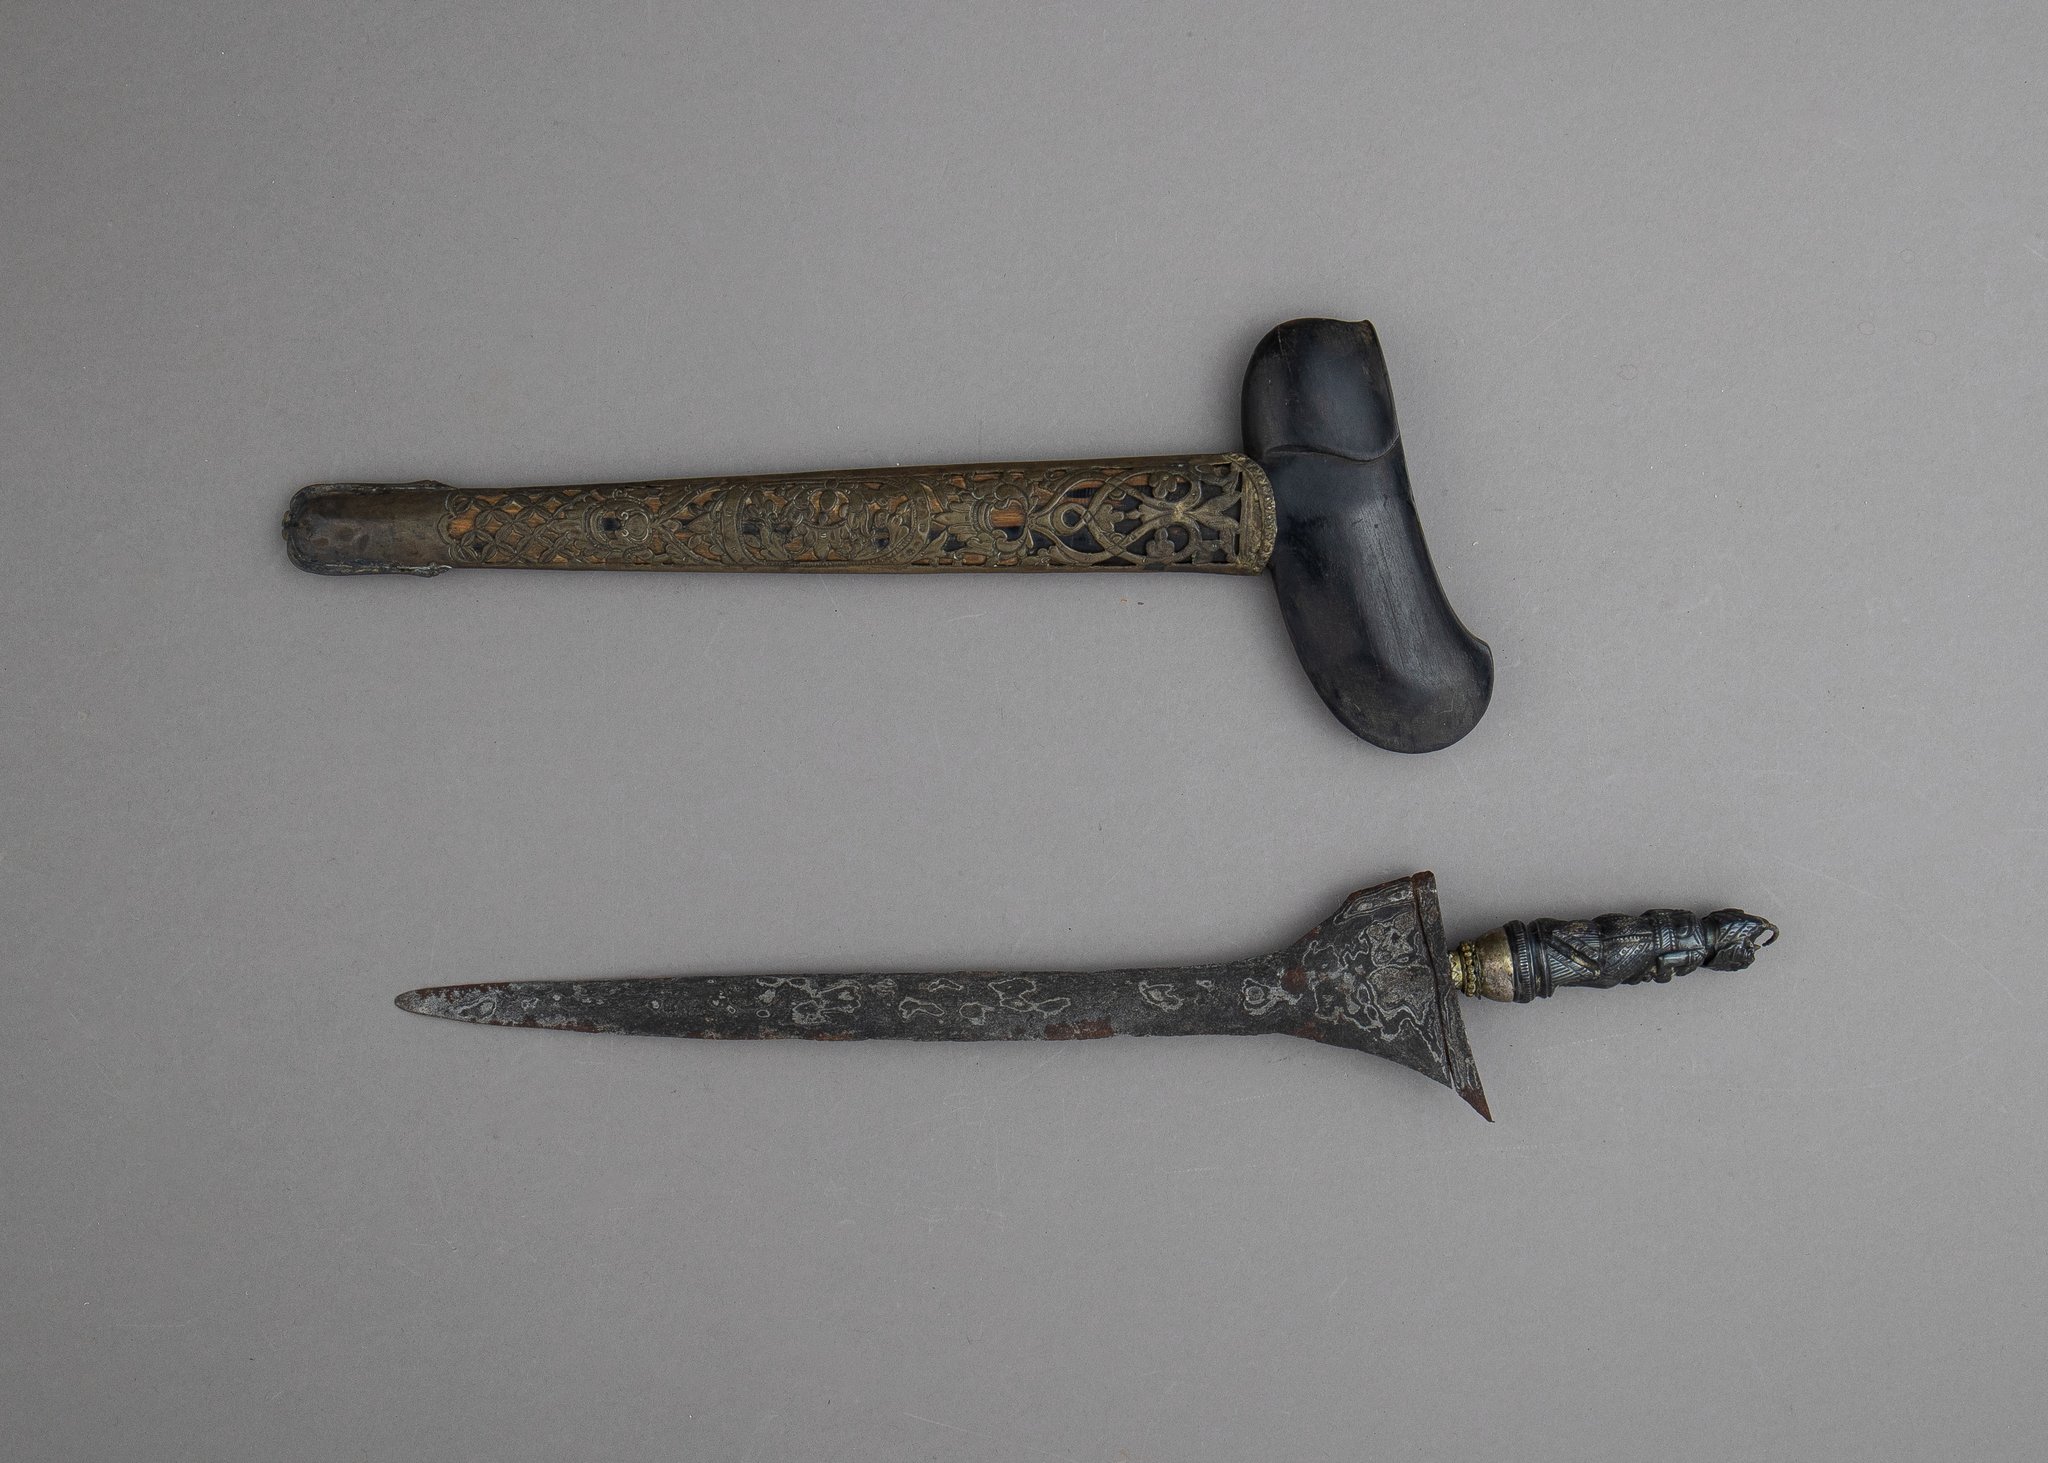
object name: kris with sheath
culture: balinese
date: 1501-1900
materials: silver, steel, wood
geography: indonesia